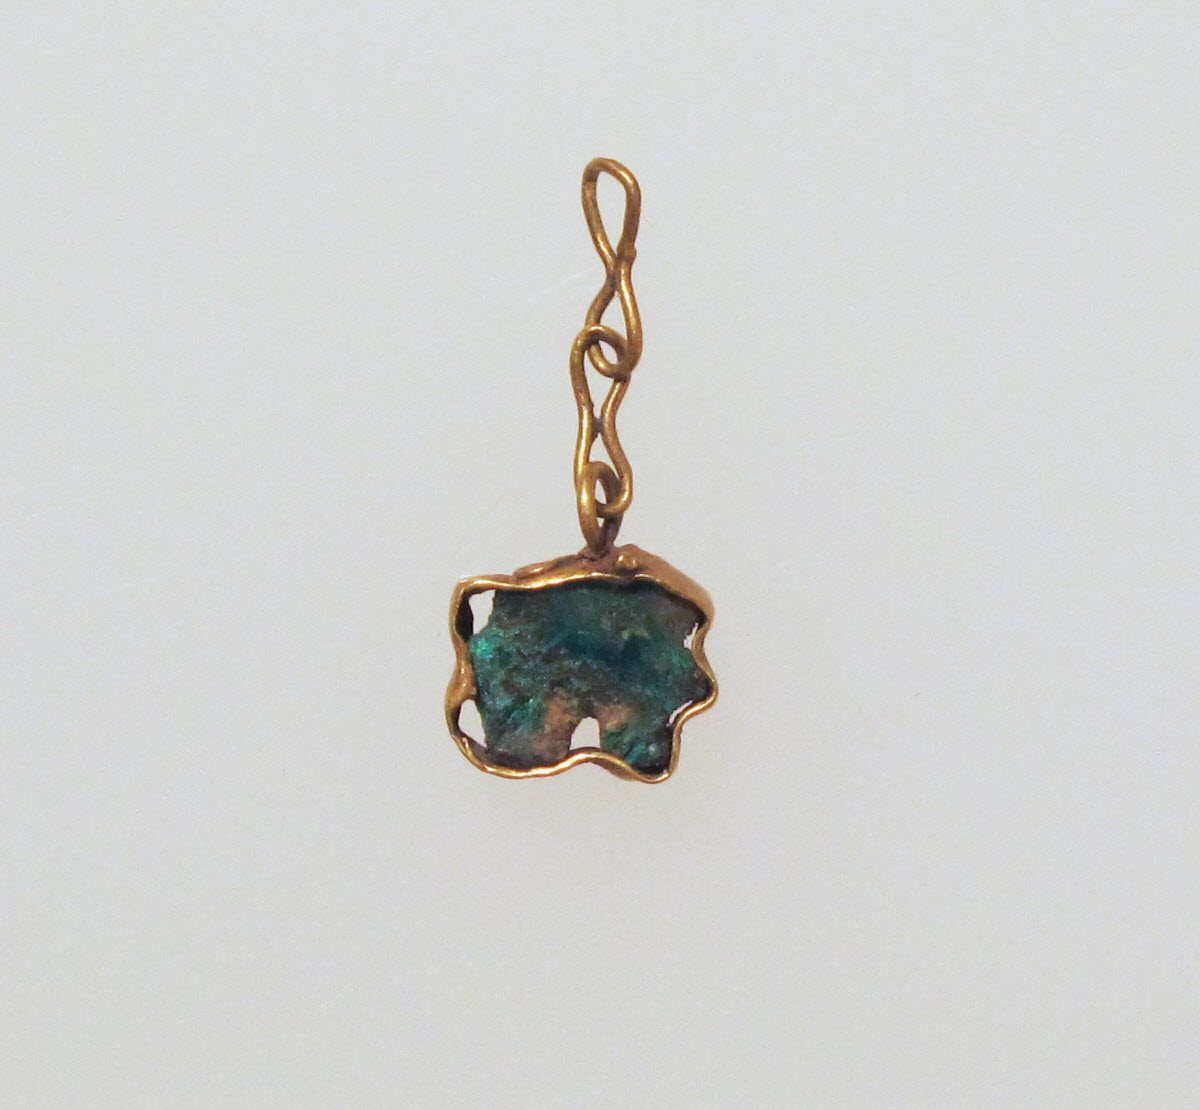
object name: pendant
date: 7000 BCE-330 CE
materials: gold